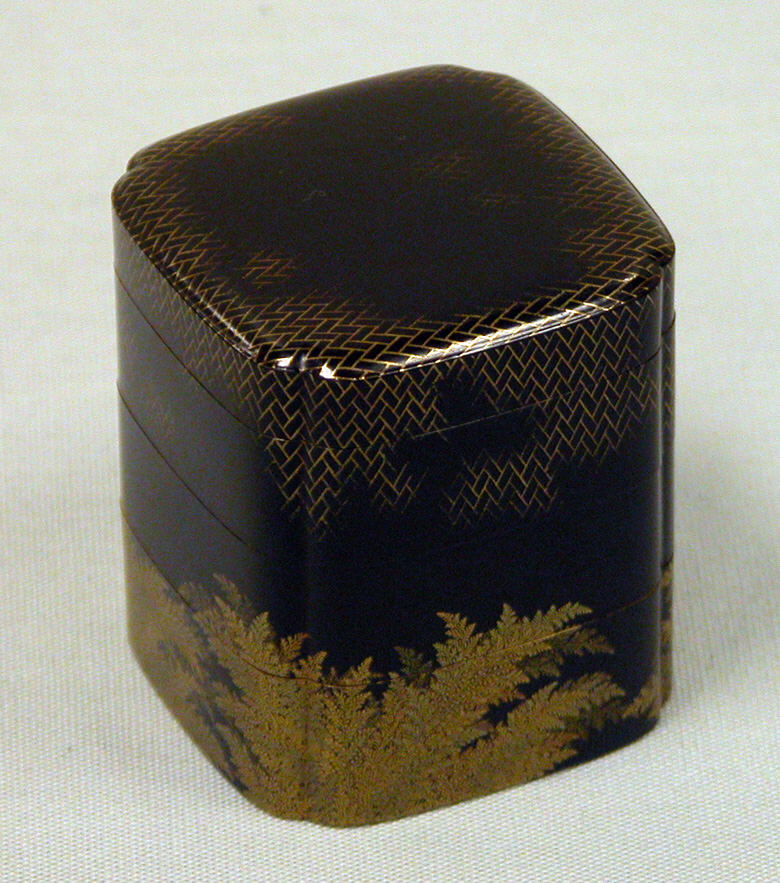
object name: box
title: Box of Three Trays with Decoration of Ferns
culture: japanese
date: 1601-1700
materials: gold, lacquer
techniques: maki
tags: leaves